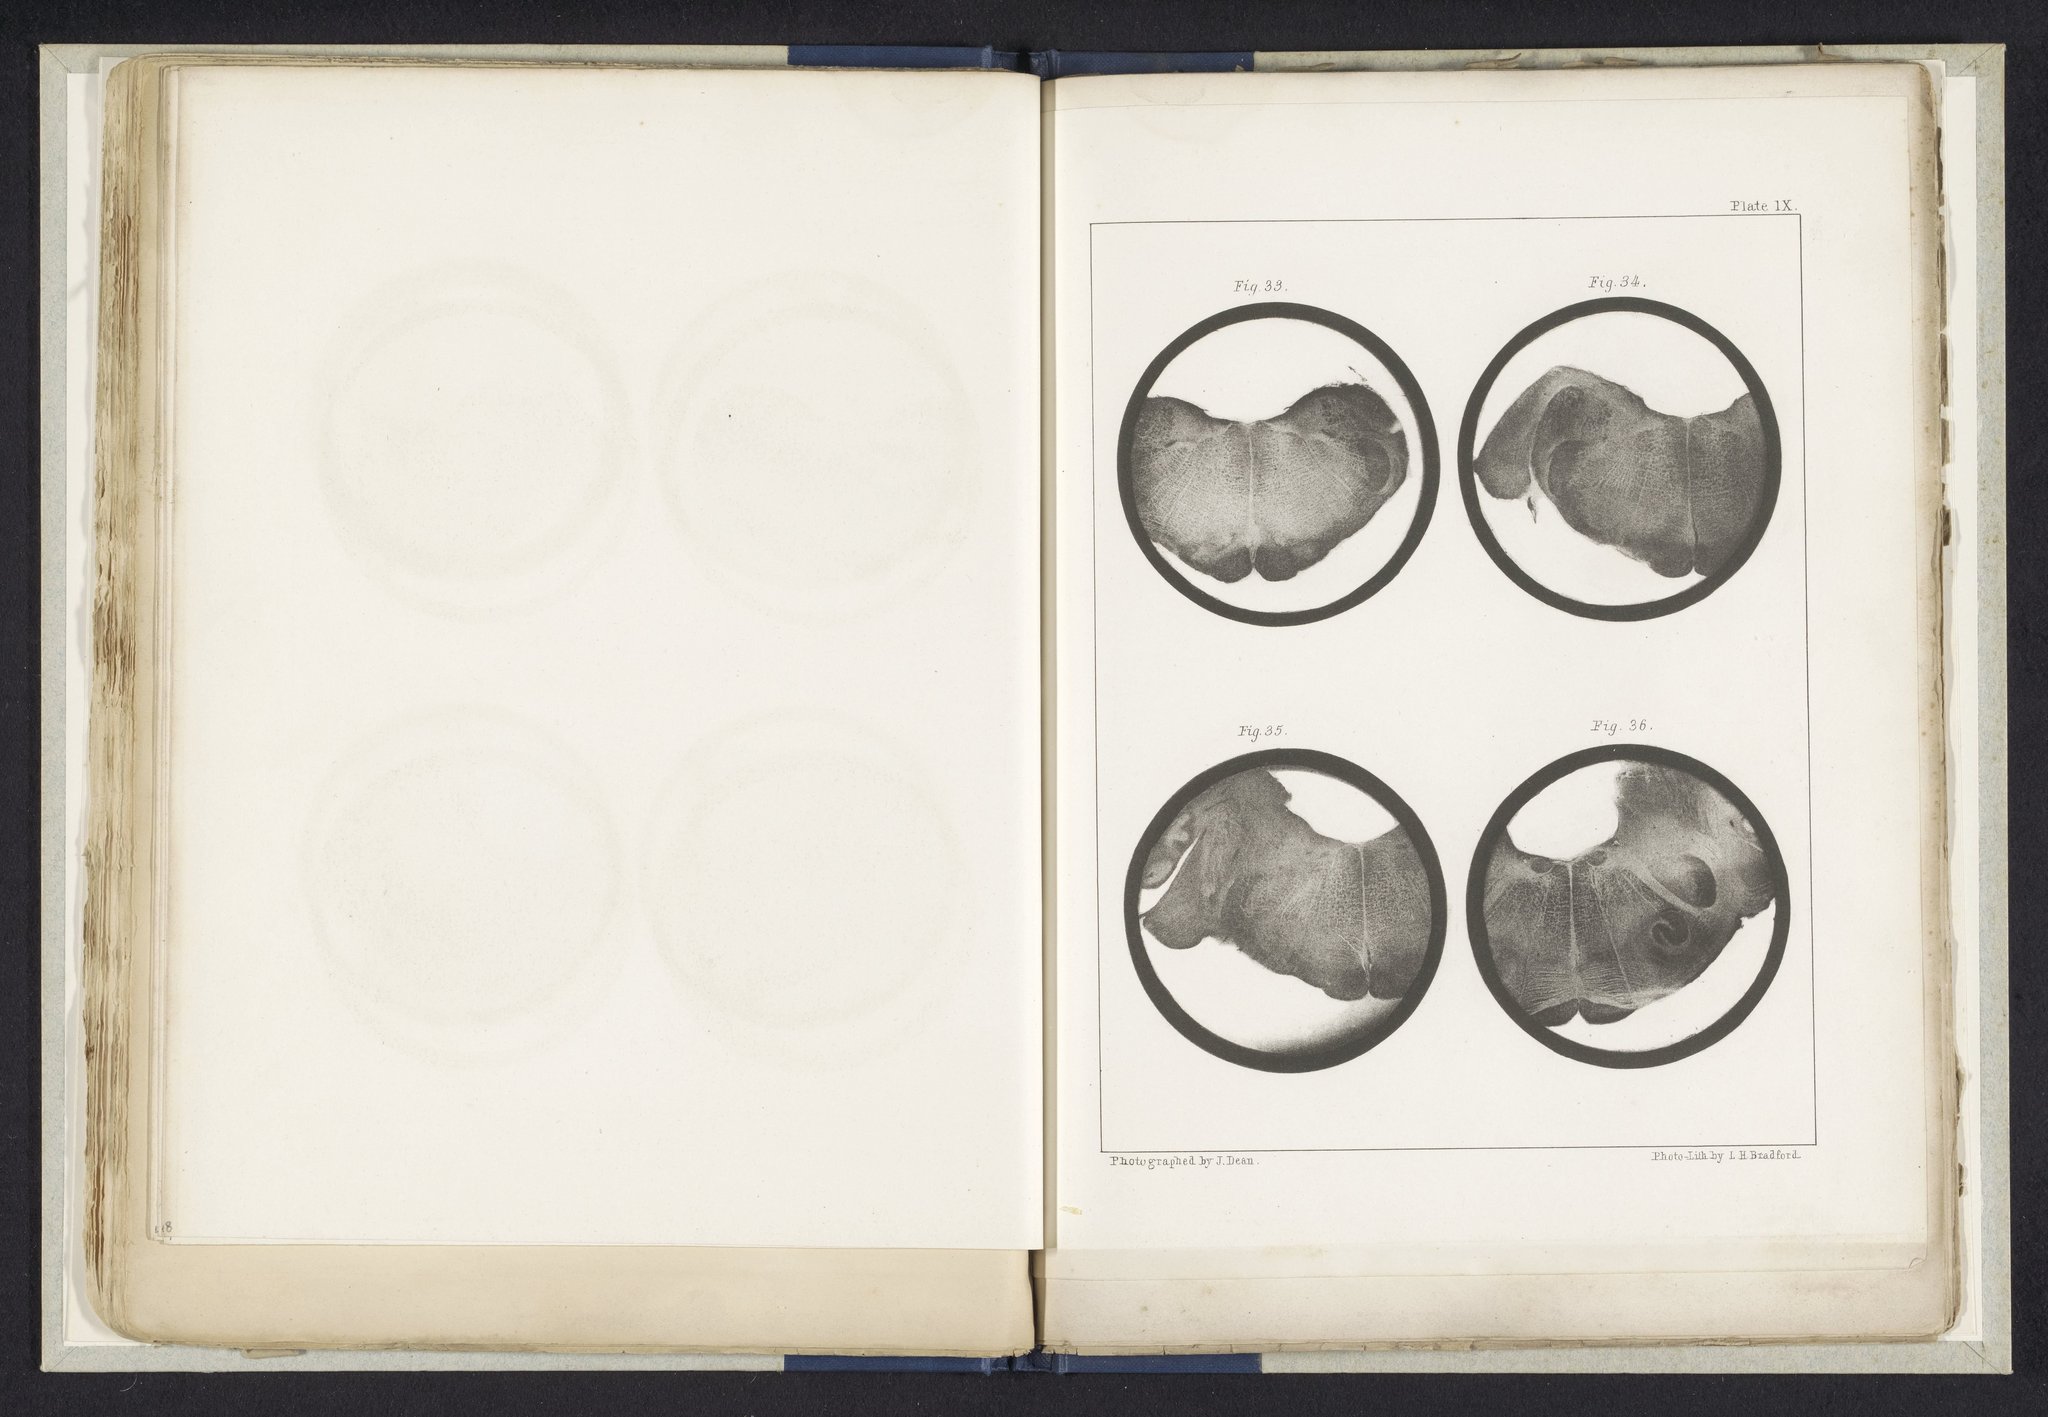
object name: page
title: Vier details van een medulla oblongata van een mens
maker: john dean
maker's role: fotograaf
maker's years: 1831-1888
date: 1854-1864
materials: paper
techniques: photolithography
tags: brains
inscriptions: number: ‘Plate IX. Fig. 33. Fig 34. Fig. 35. Fig. 36.’